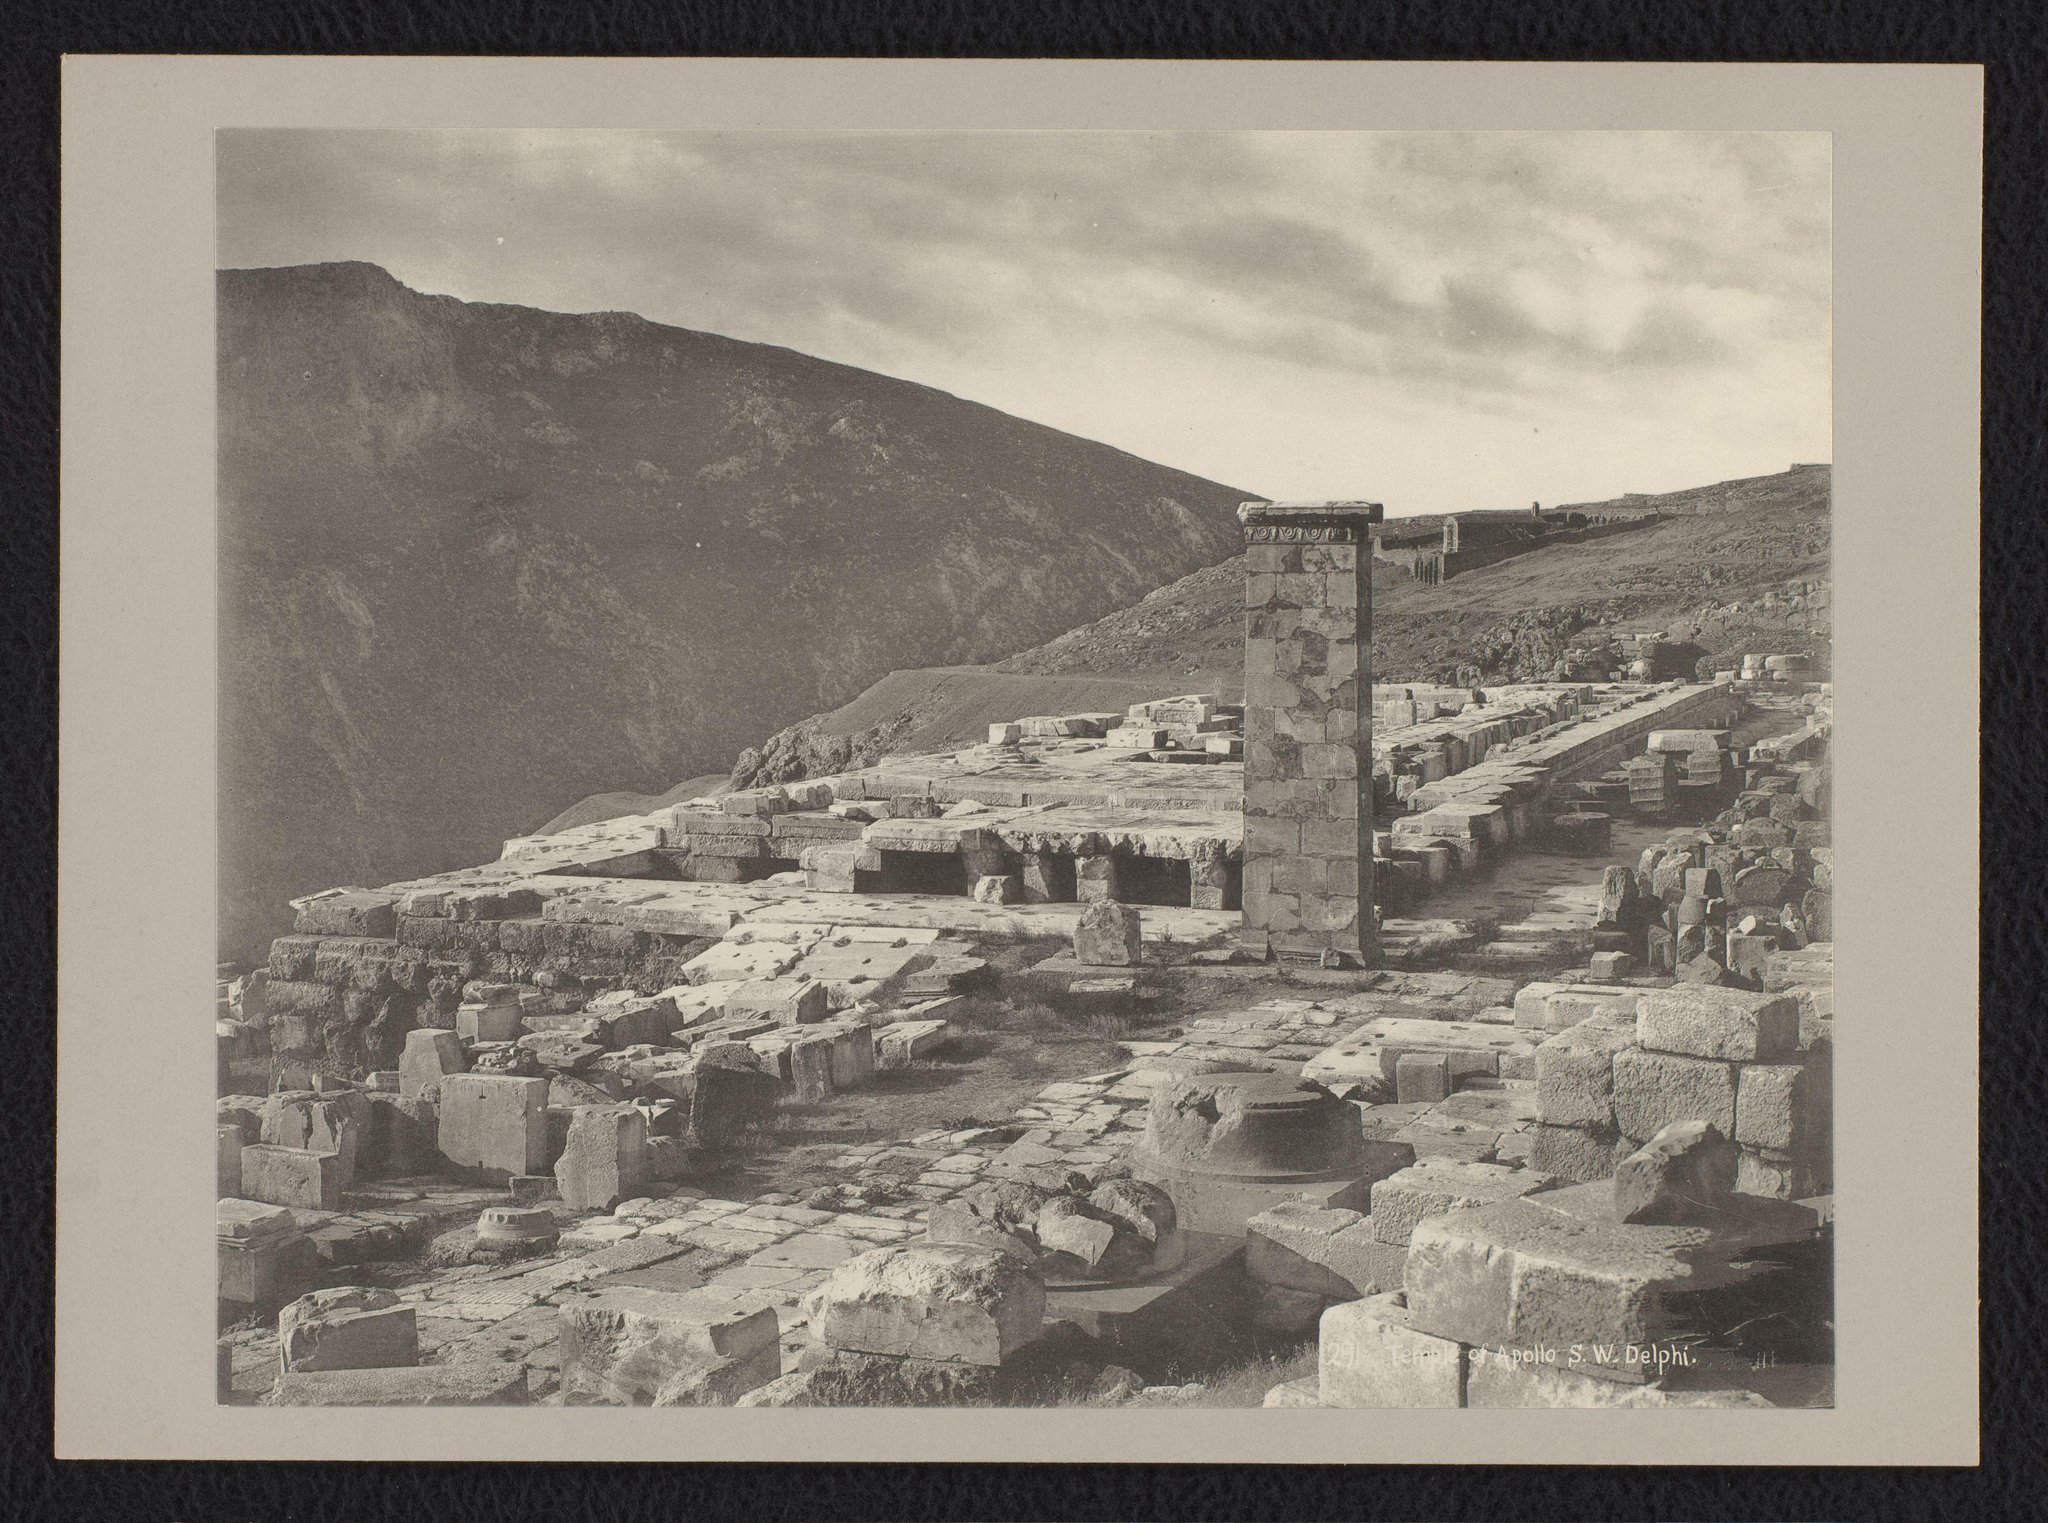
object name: photograph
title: Tempel van Apollo bij Delphi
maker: Anonymous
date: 1895-1915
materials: cardboard, paper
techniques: photograph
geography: delphi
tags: delphi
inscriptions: annotation: ‘17. Tempel van Apollo, alwaar het orakel was.’